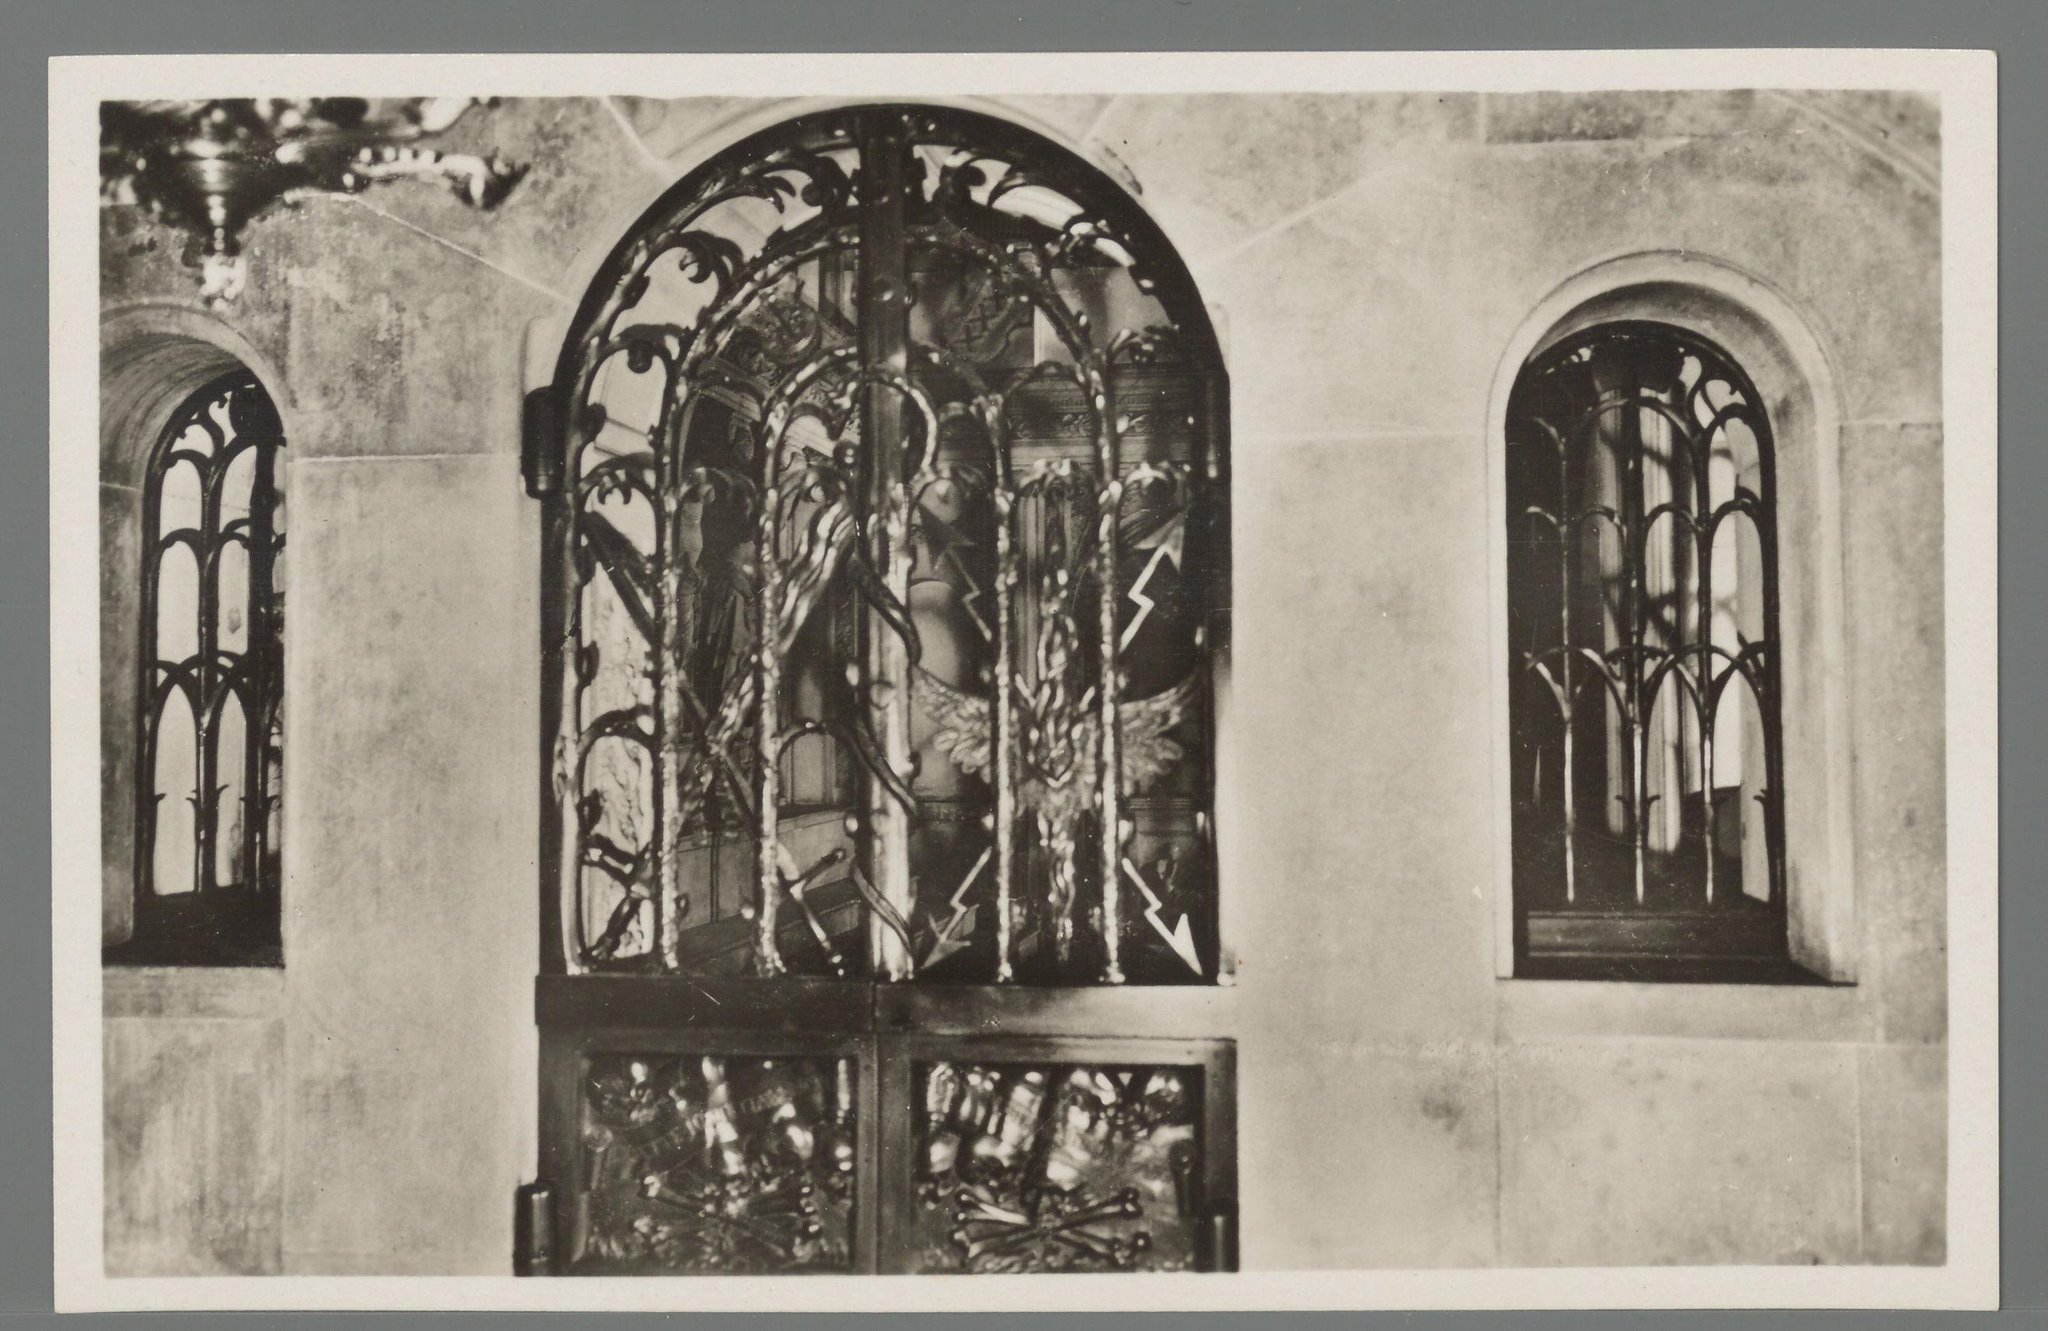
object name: ansichtkaart, prentbriefkaart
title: Koninklijk Paleis Amsterdam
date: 1932-1947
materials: photographic support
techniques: photography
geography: amsterdam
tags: palace - aa - civic architecture: inside, decorations (interior of the house), administration of justice, trial, royal palace of amsterdam